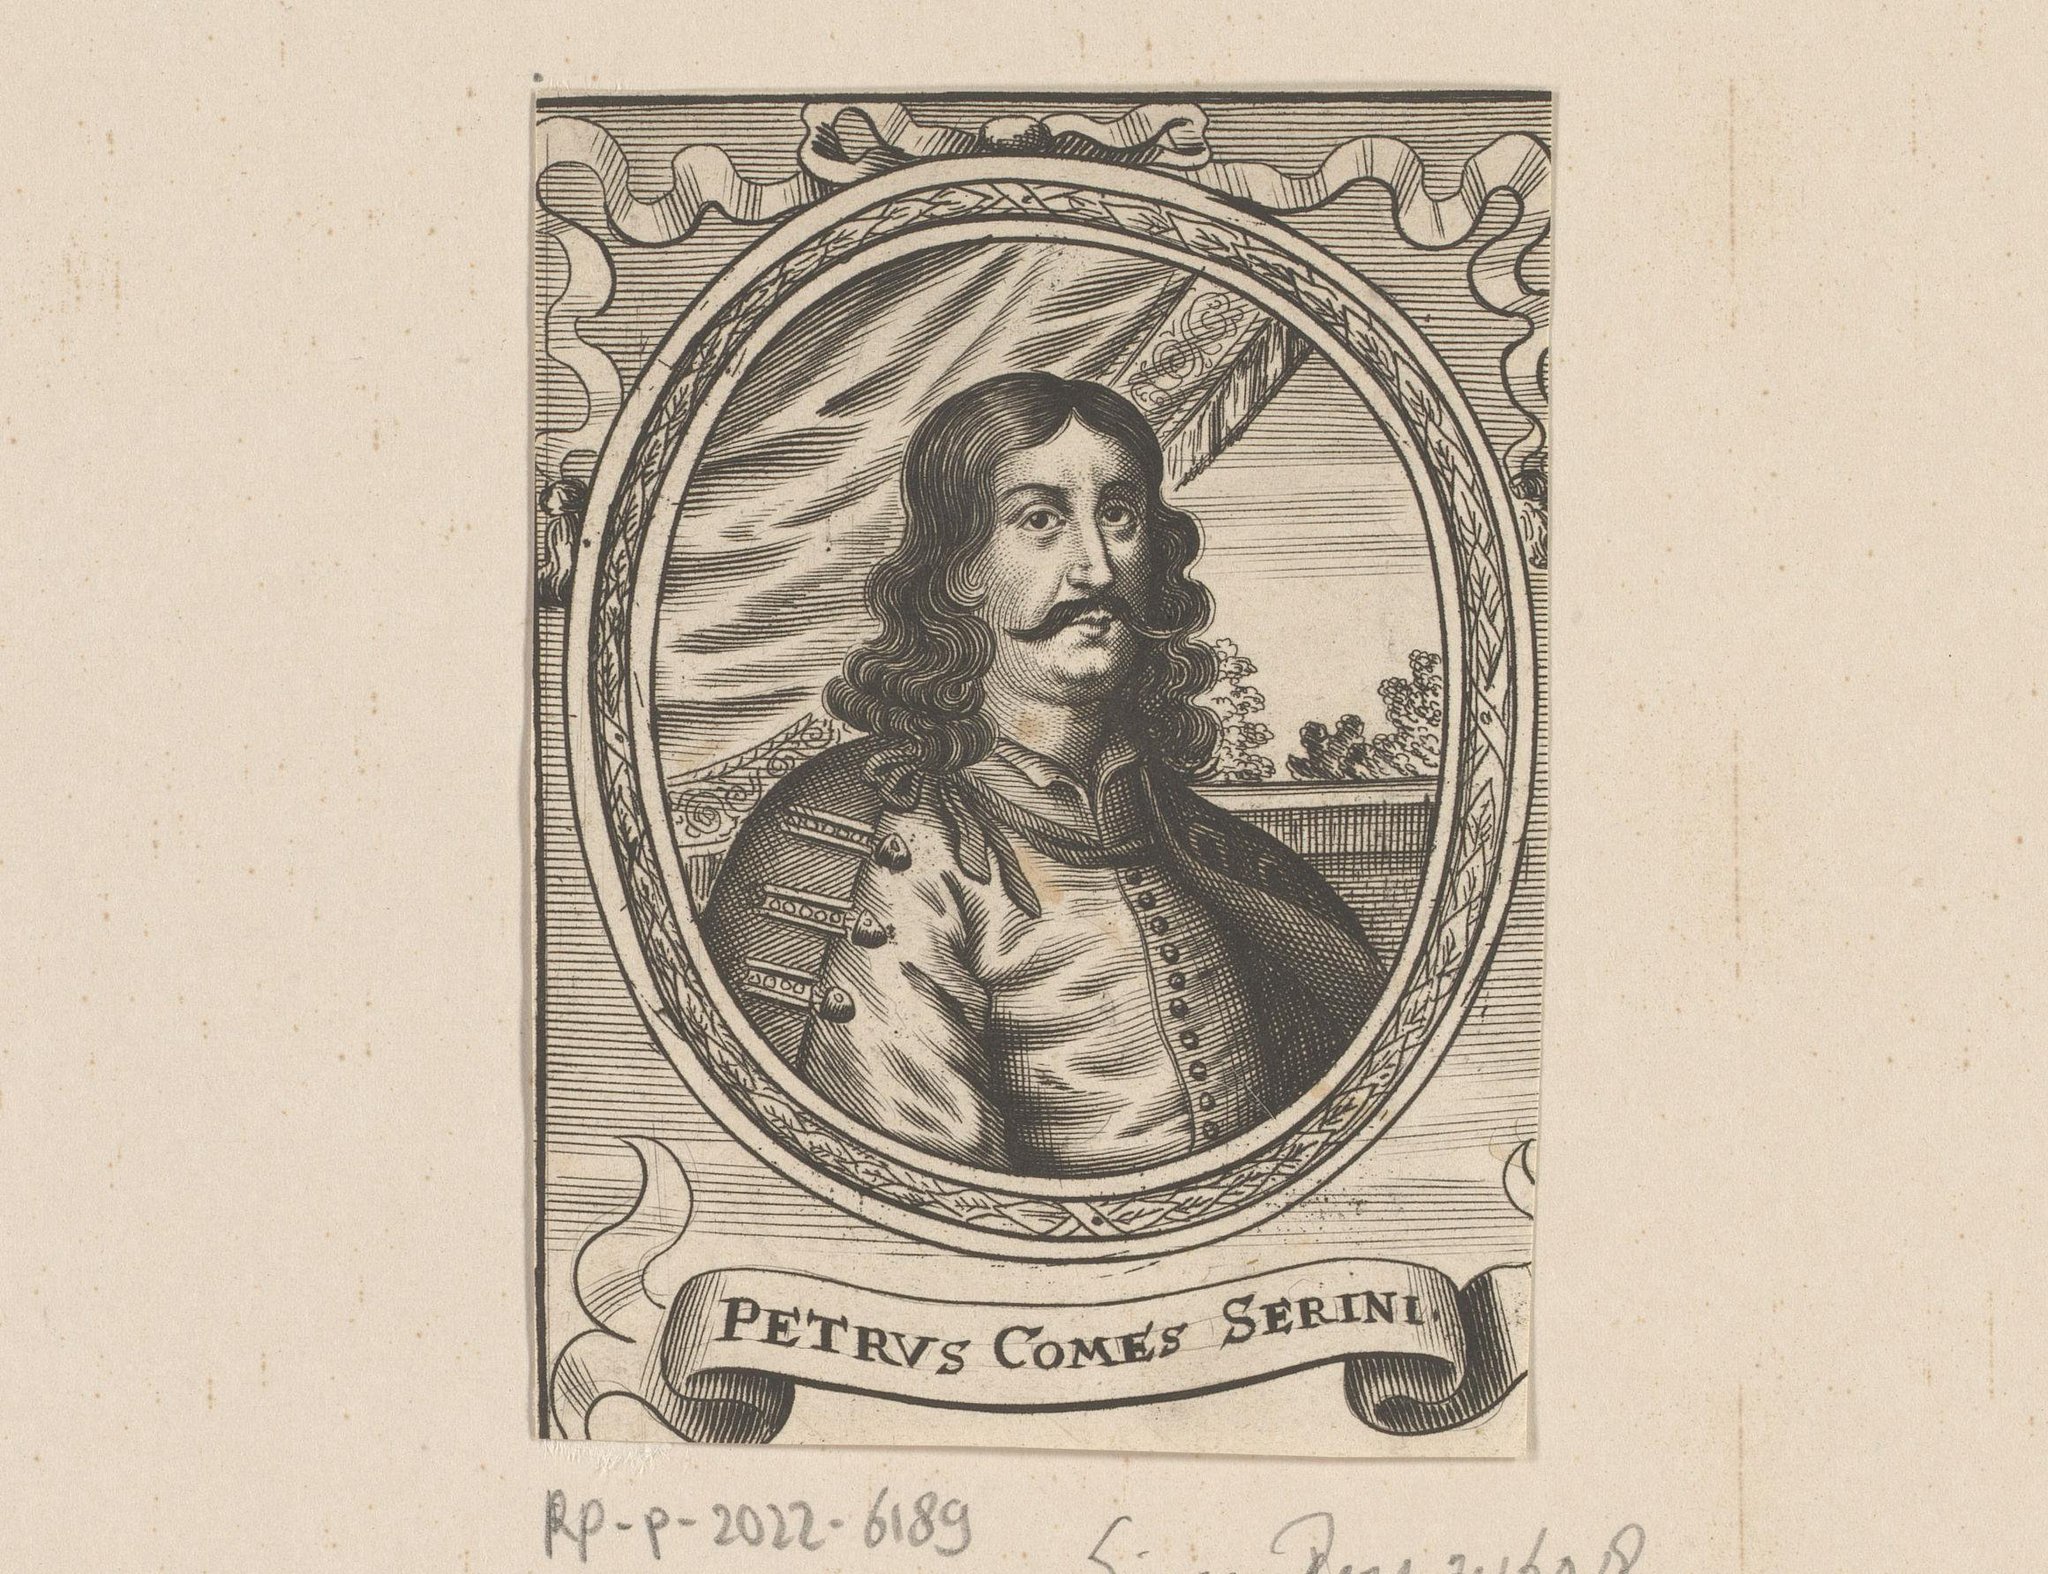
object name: print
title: Portret van Petar Zrinski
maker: Anonymous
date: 1631-1671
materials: paper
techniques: engraving, etching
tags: commander-in-chief, general, marshal, historical persons